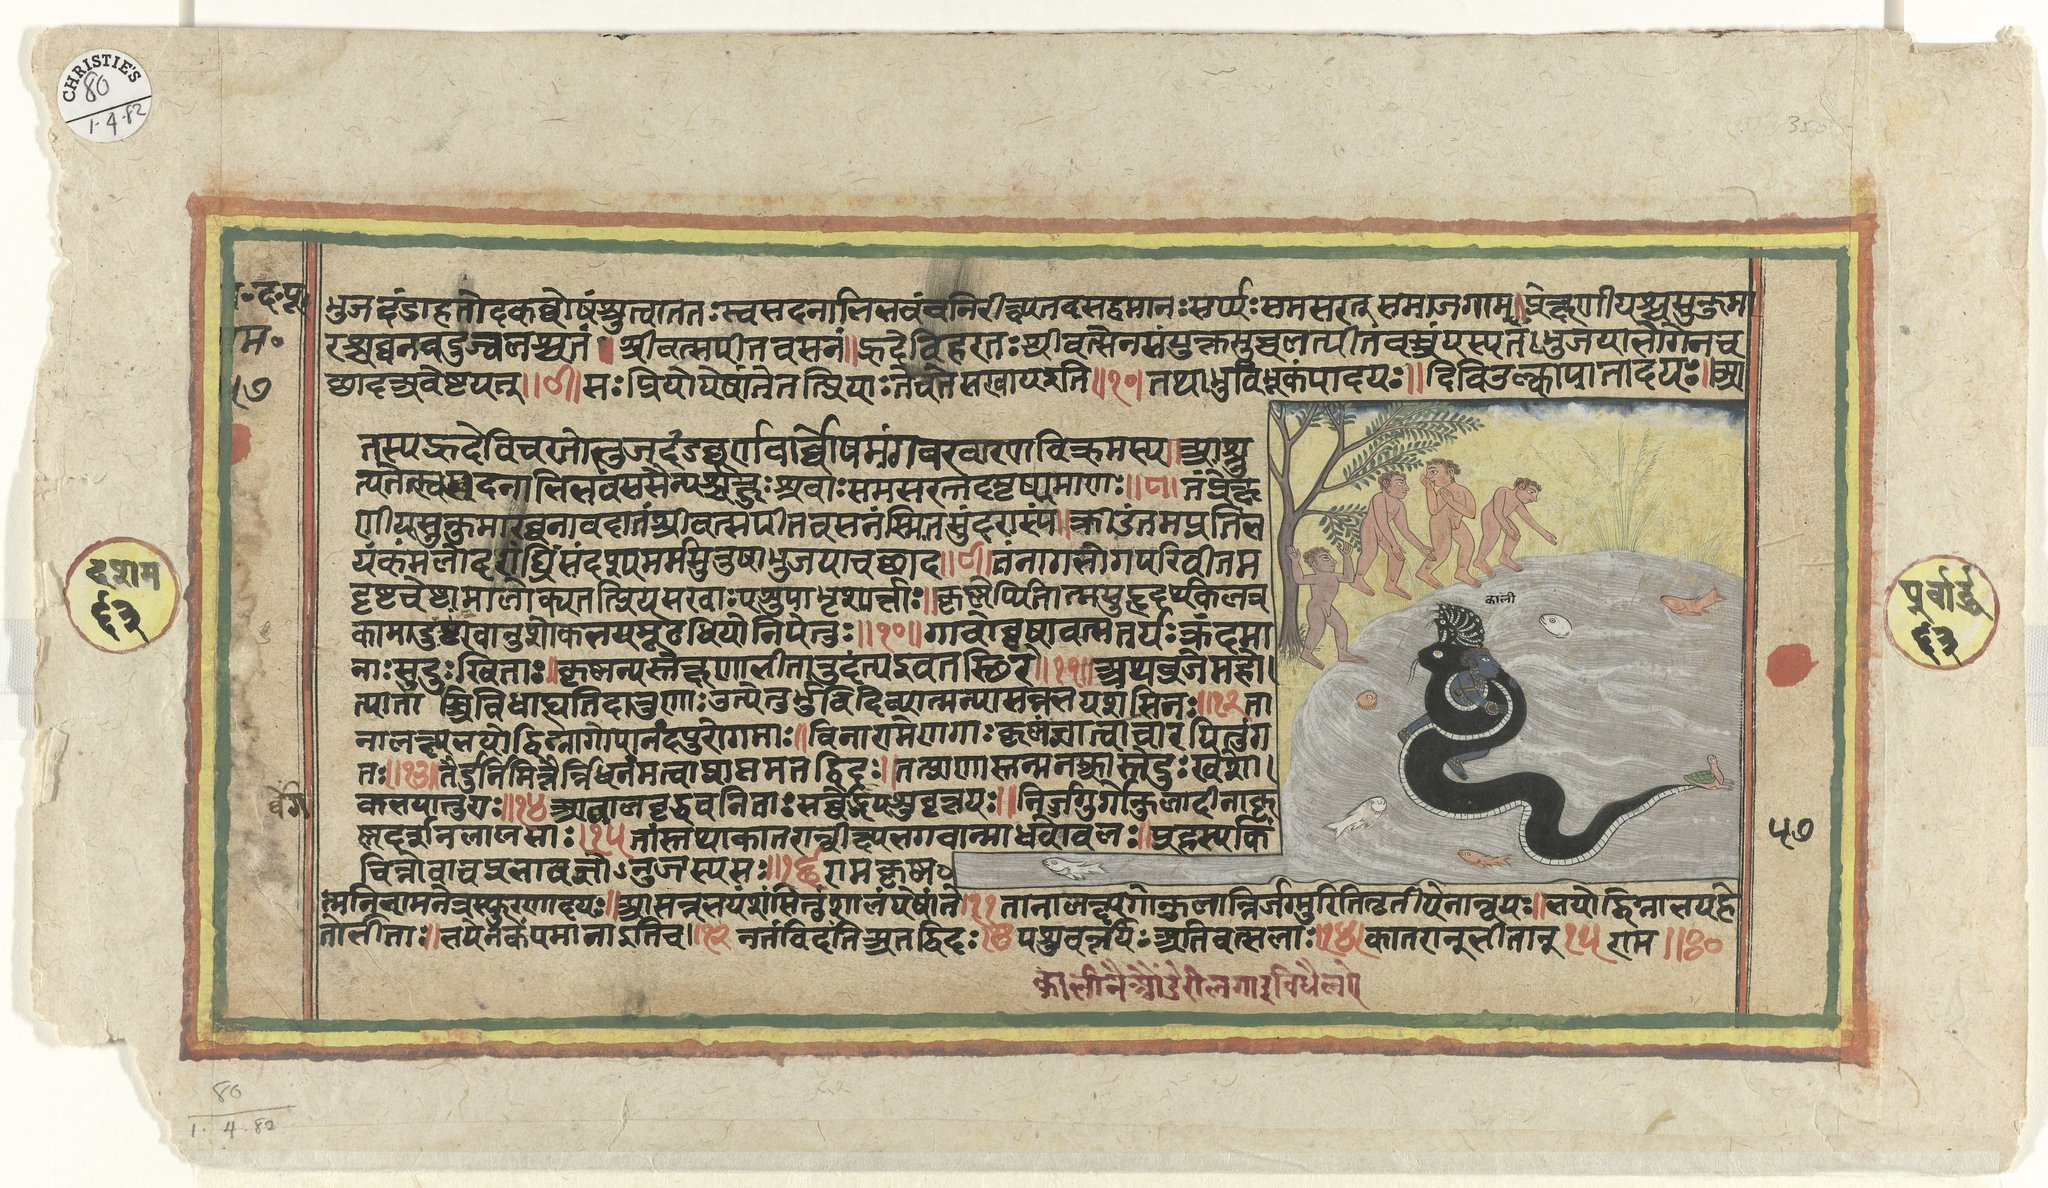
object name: indian miniature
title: Krishna bestrijdt de slang Kalya terwijl vier herdersjongens toekijken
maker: Anonymous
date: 1614-1640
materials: paper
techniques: brush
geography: mewar